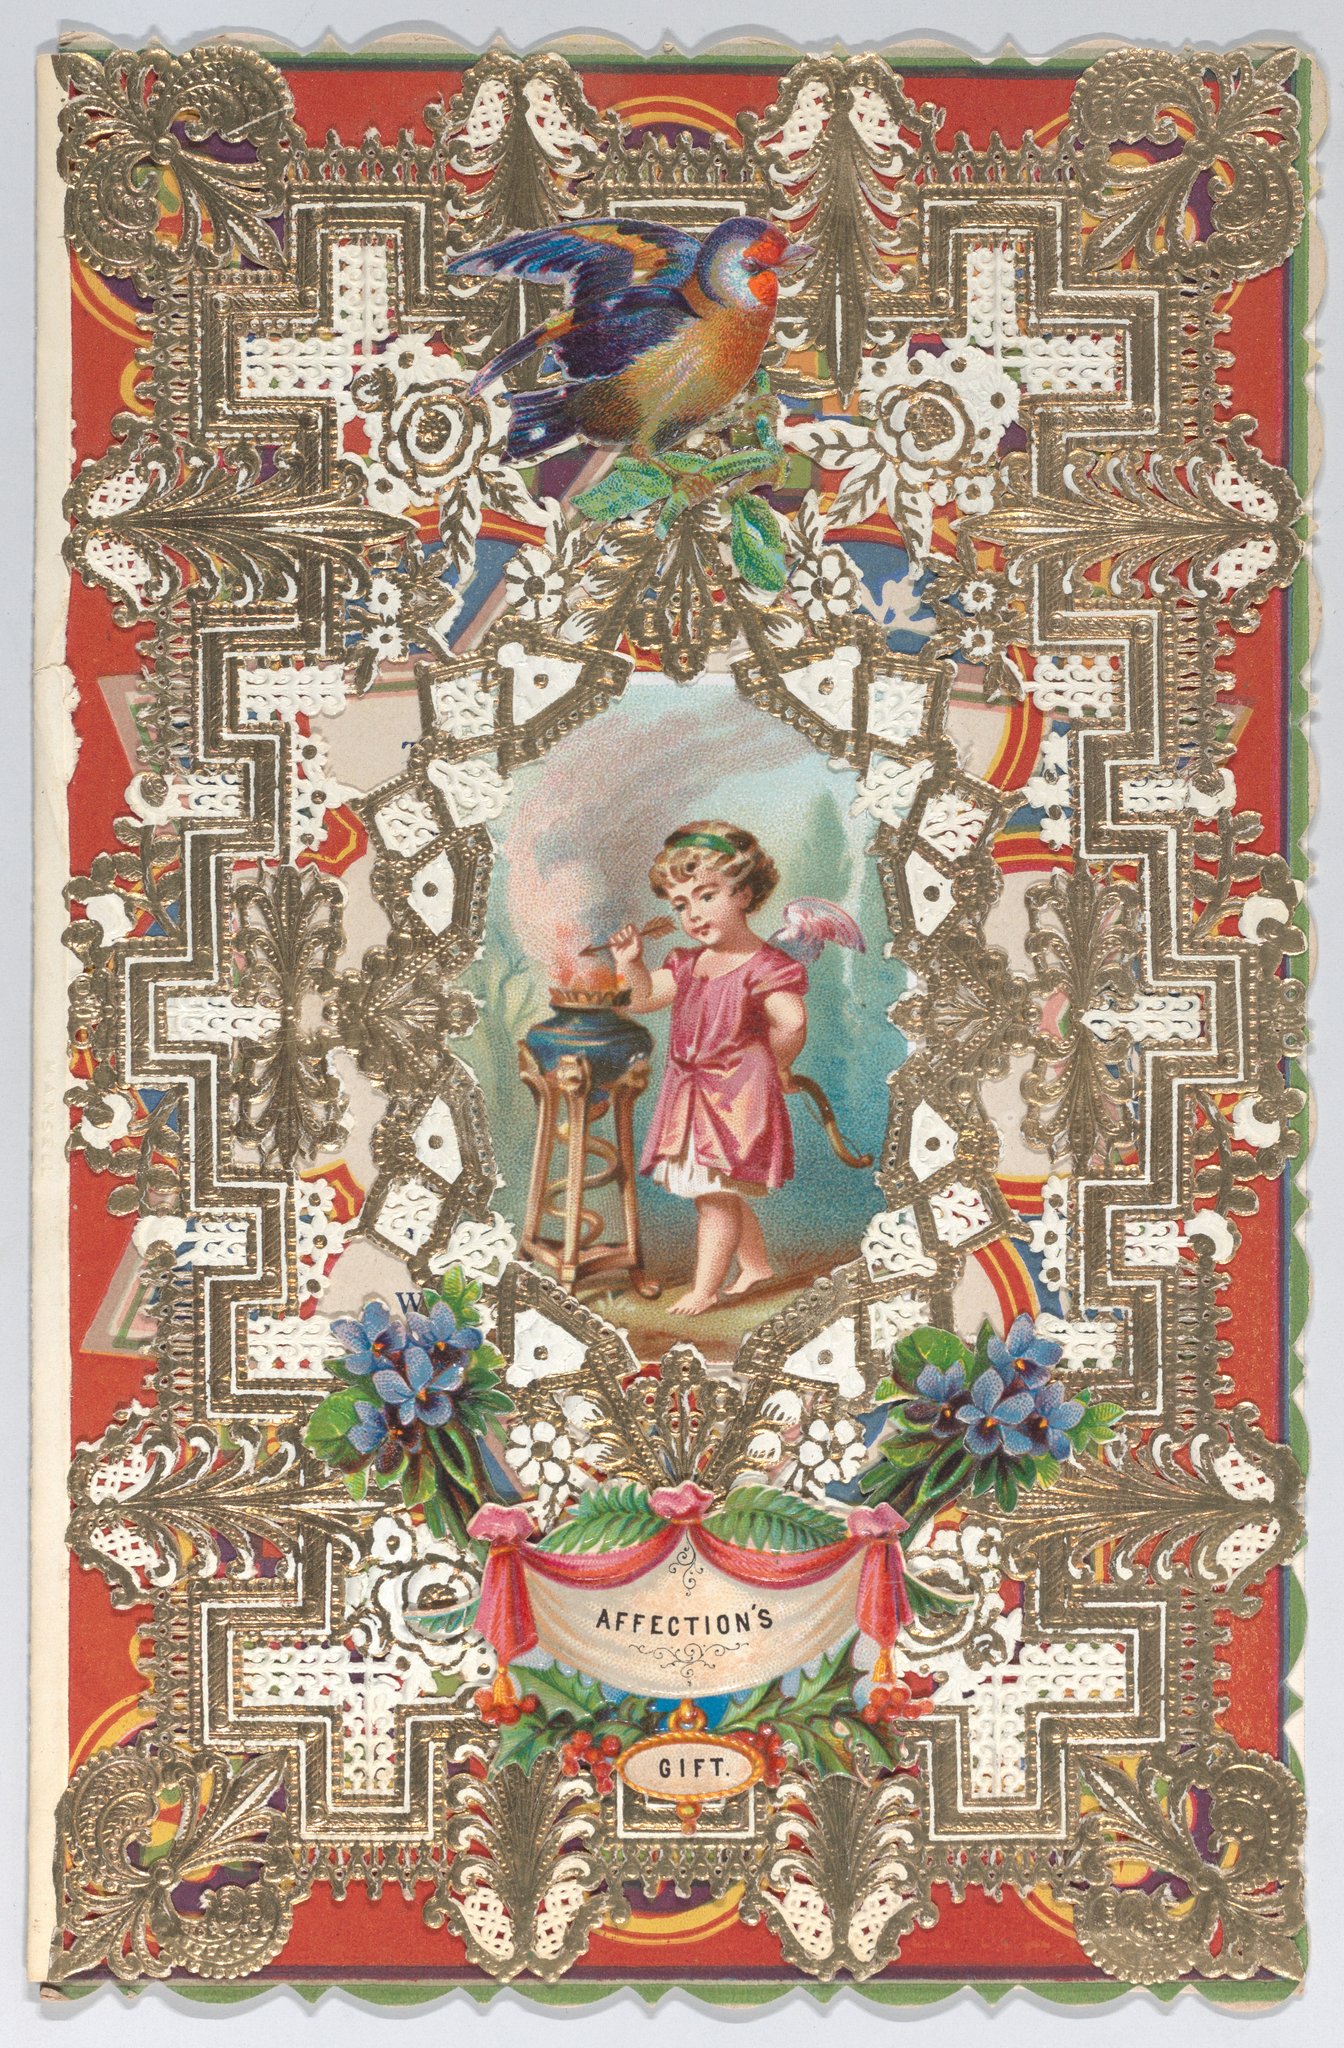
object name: valentine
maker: Anonymous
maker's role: artist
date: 1880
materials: lace, paper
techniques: chromolithography, cutting, embossing, gilding, open work